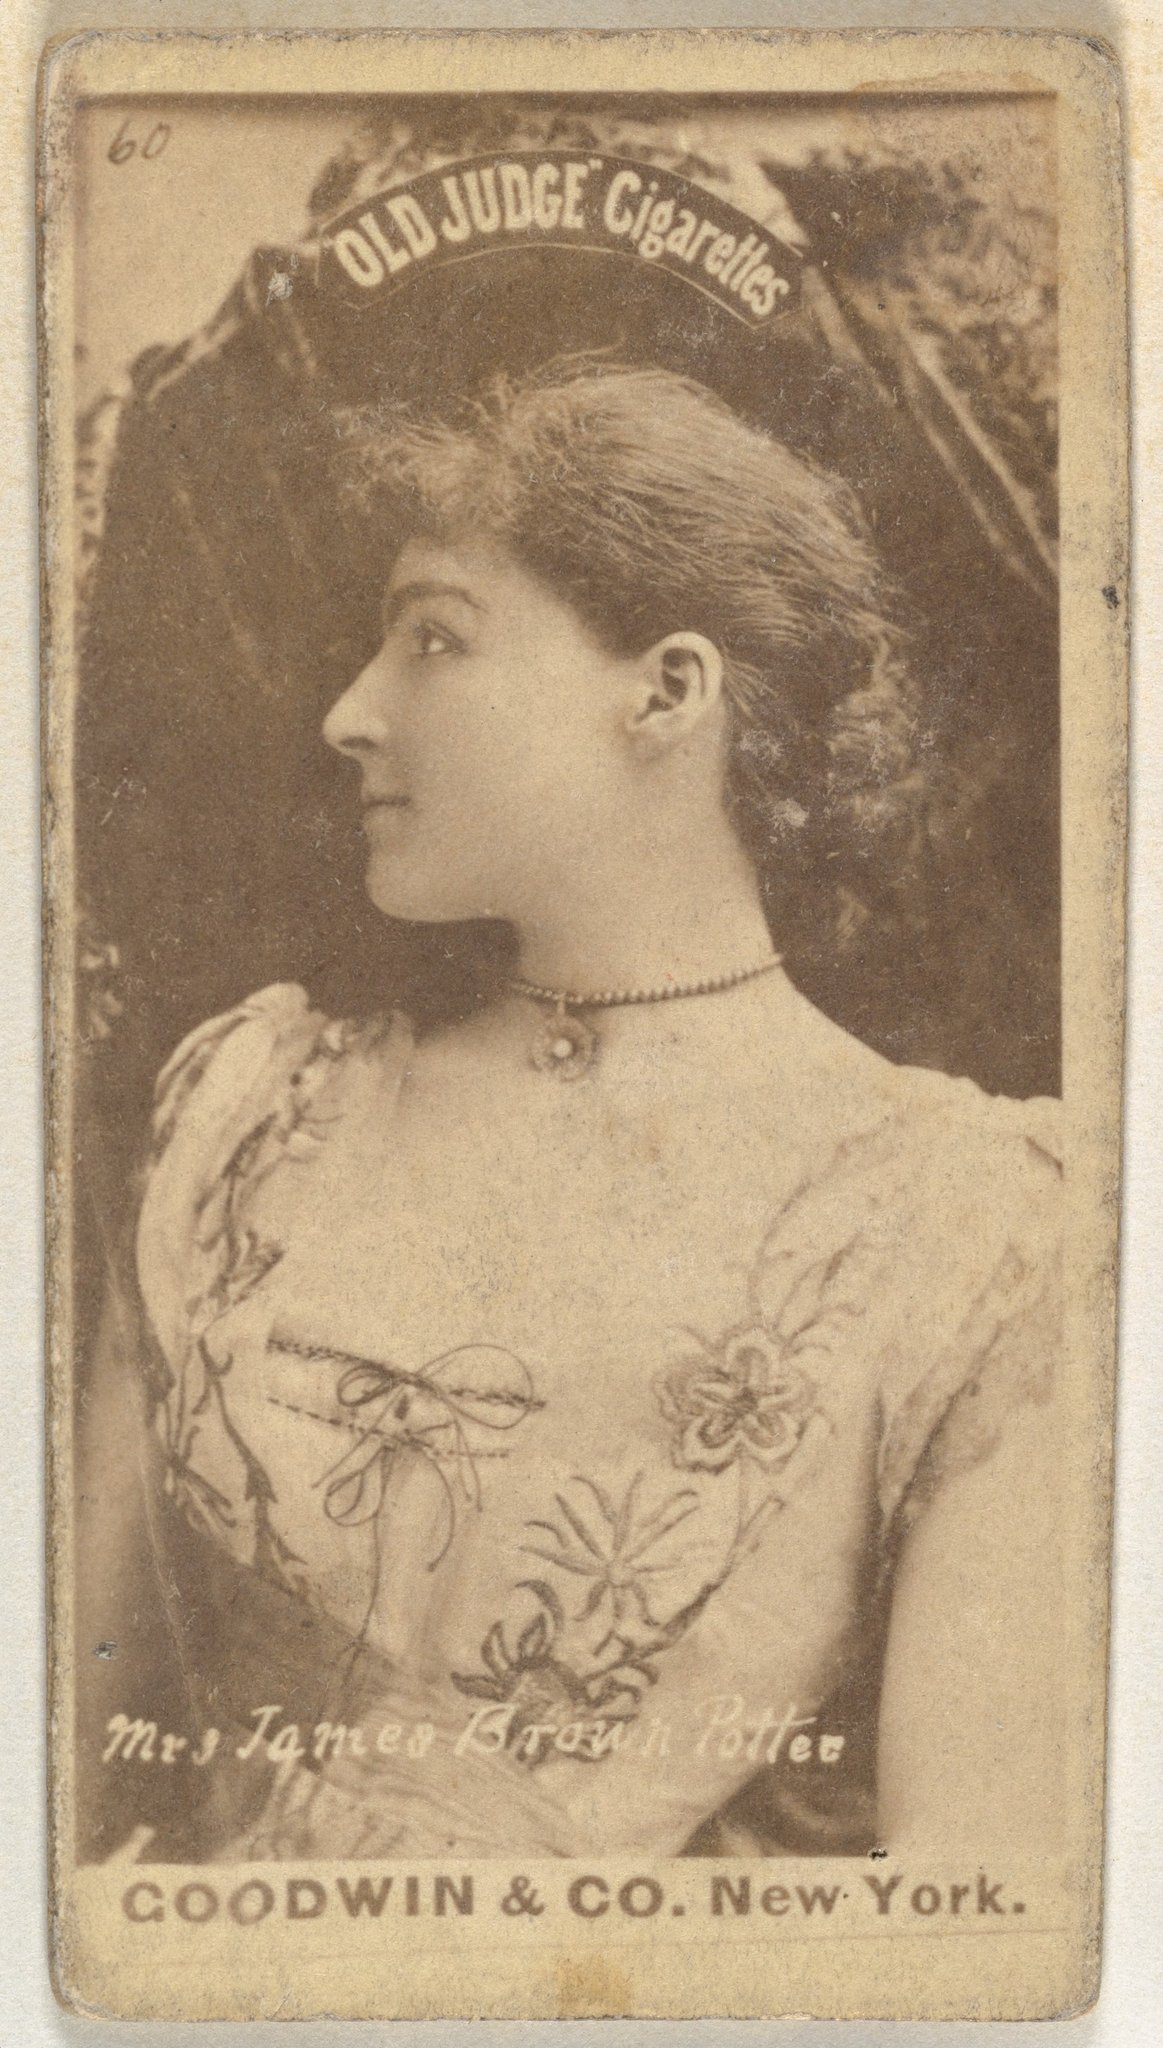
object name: photograph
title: Mrs. James Brown Potter, from the Actors and Actresses series (N171) for Old Judge Cigarettes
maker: goodwin & company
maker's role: publisher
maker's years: 1850-1950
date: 1886-1890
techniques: albumen silver print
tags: profiles,women,actresses